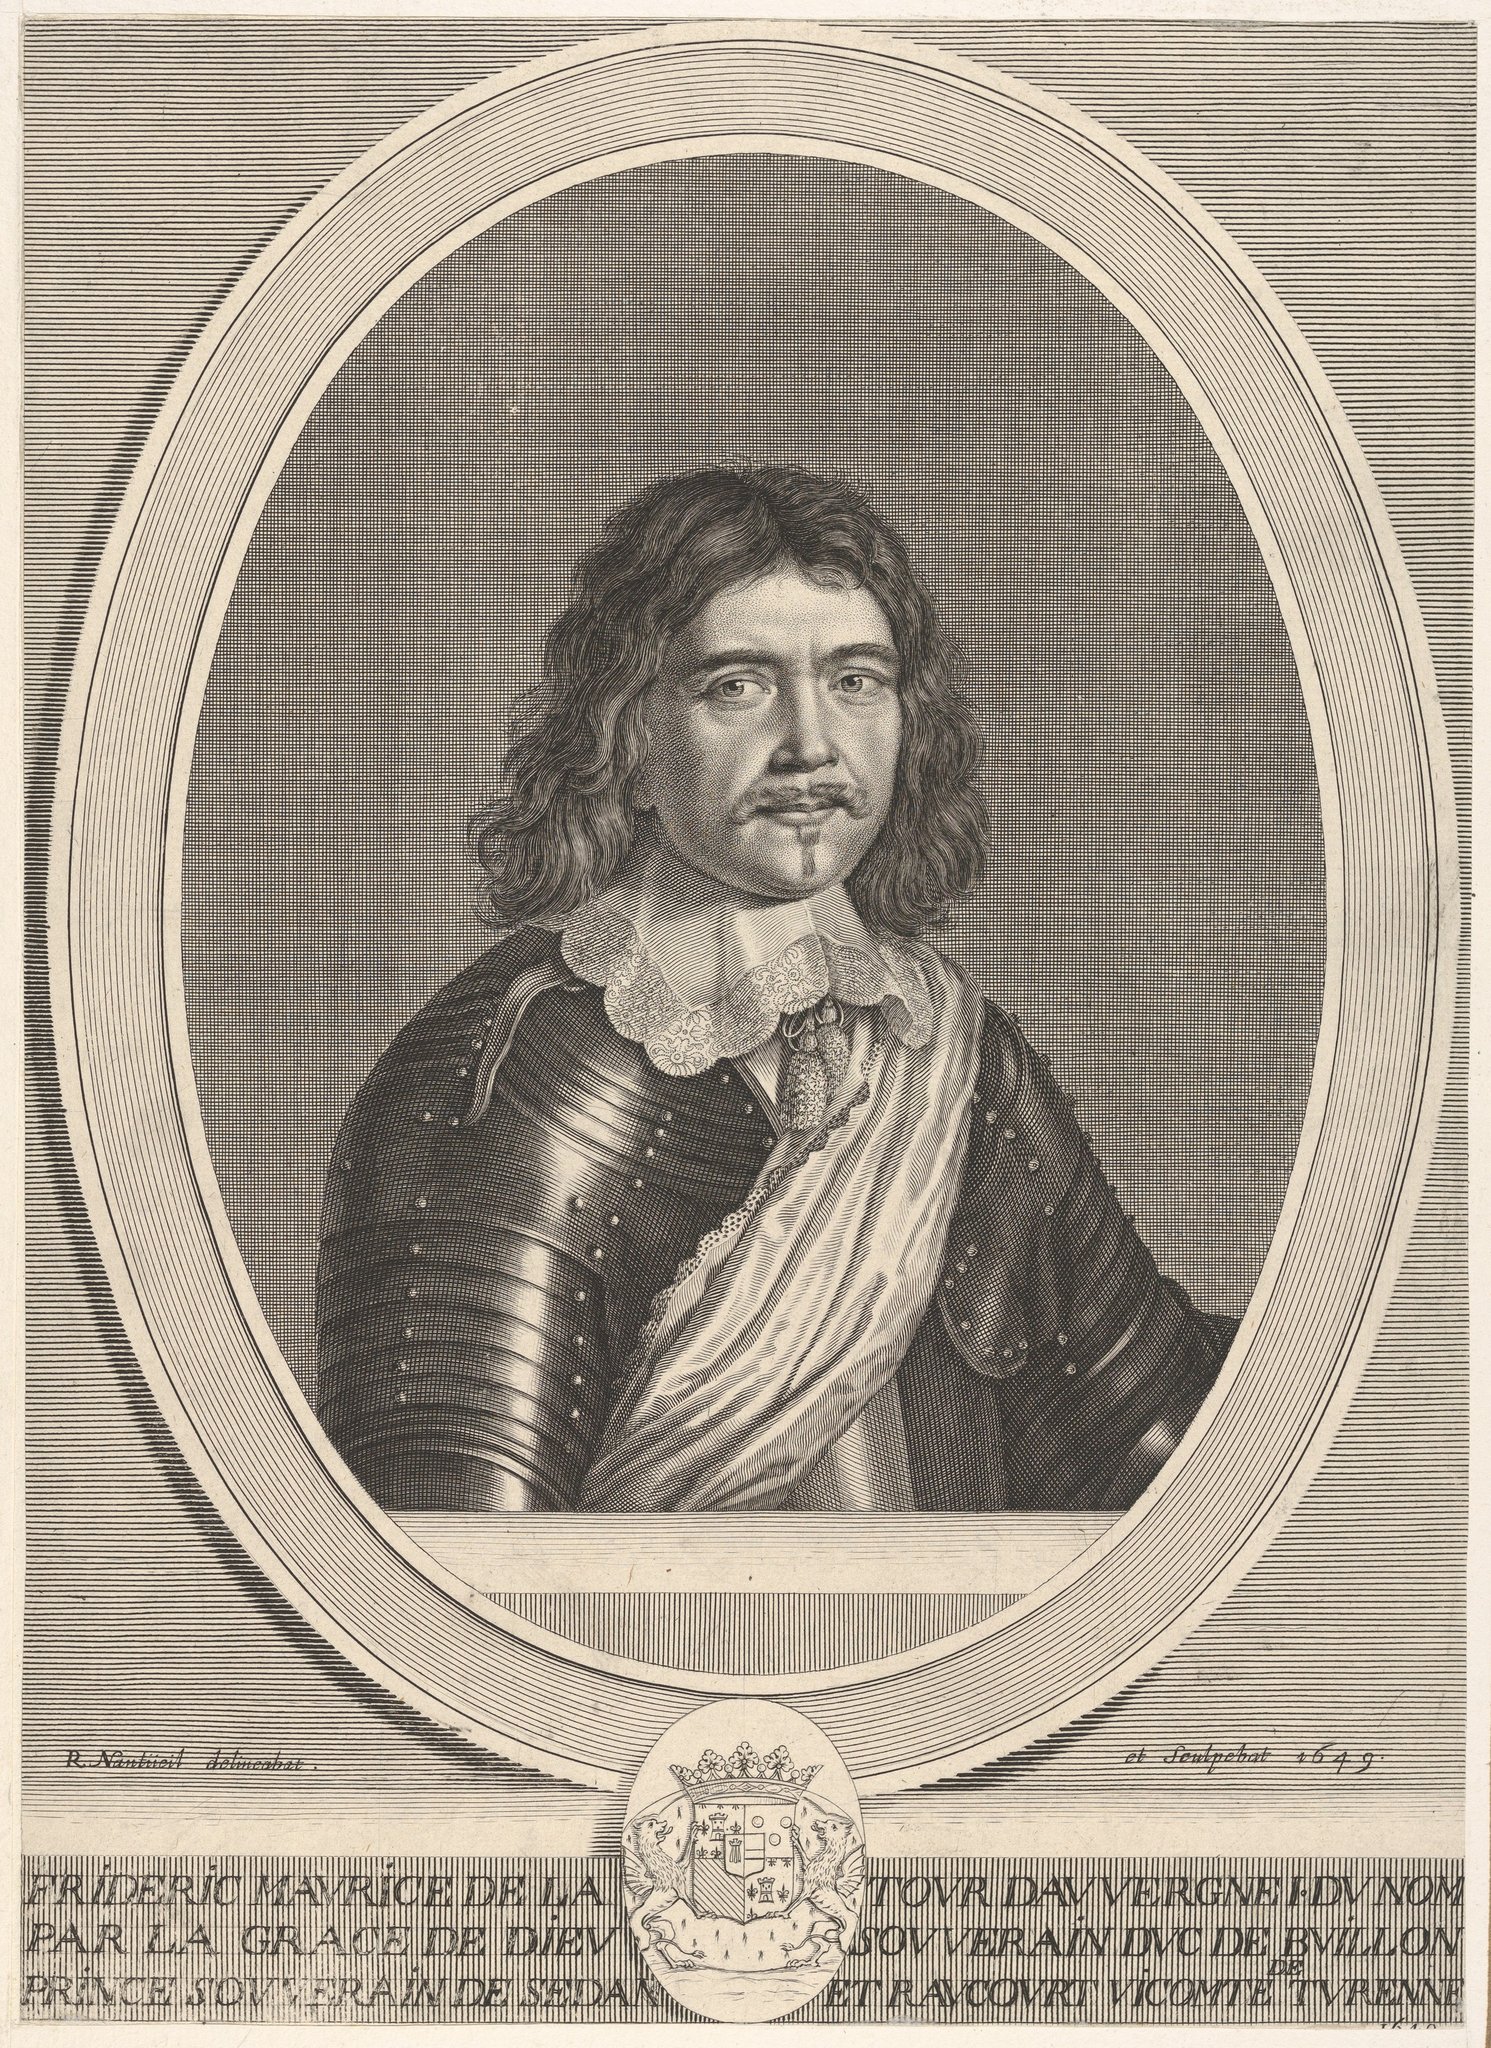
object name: print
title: Frédéric-Maurice de la Tour d'Auvergne, duc de Bouillon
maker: robert nanteuil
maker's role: artist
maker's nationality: french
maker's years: 1623-1678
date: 1649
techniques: engraving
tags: men,portraits,coat of arms